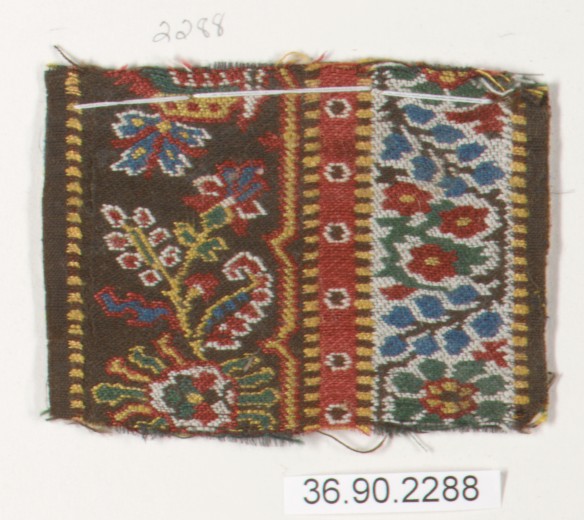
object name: border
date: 1801-1900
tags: flowers